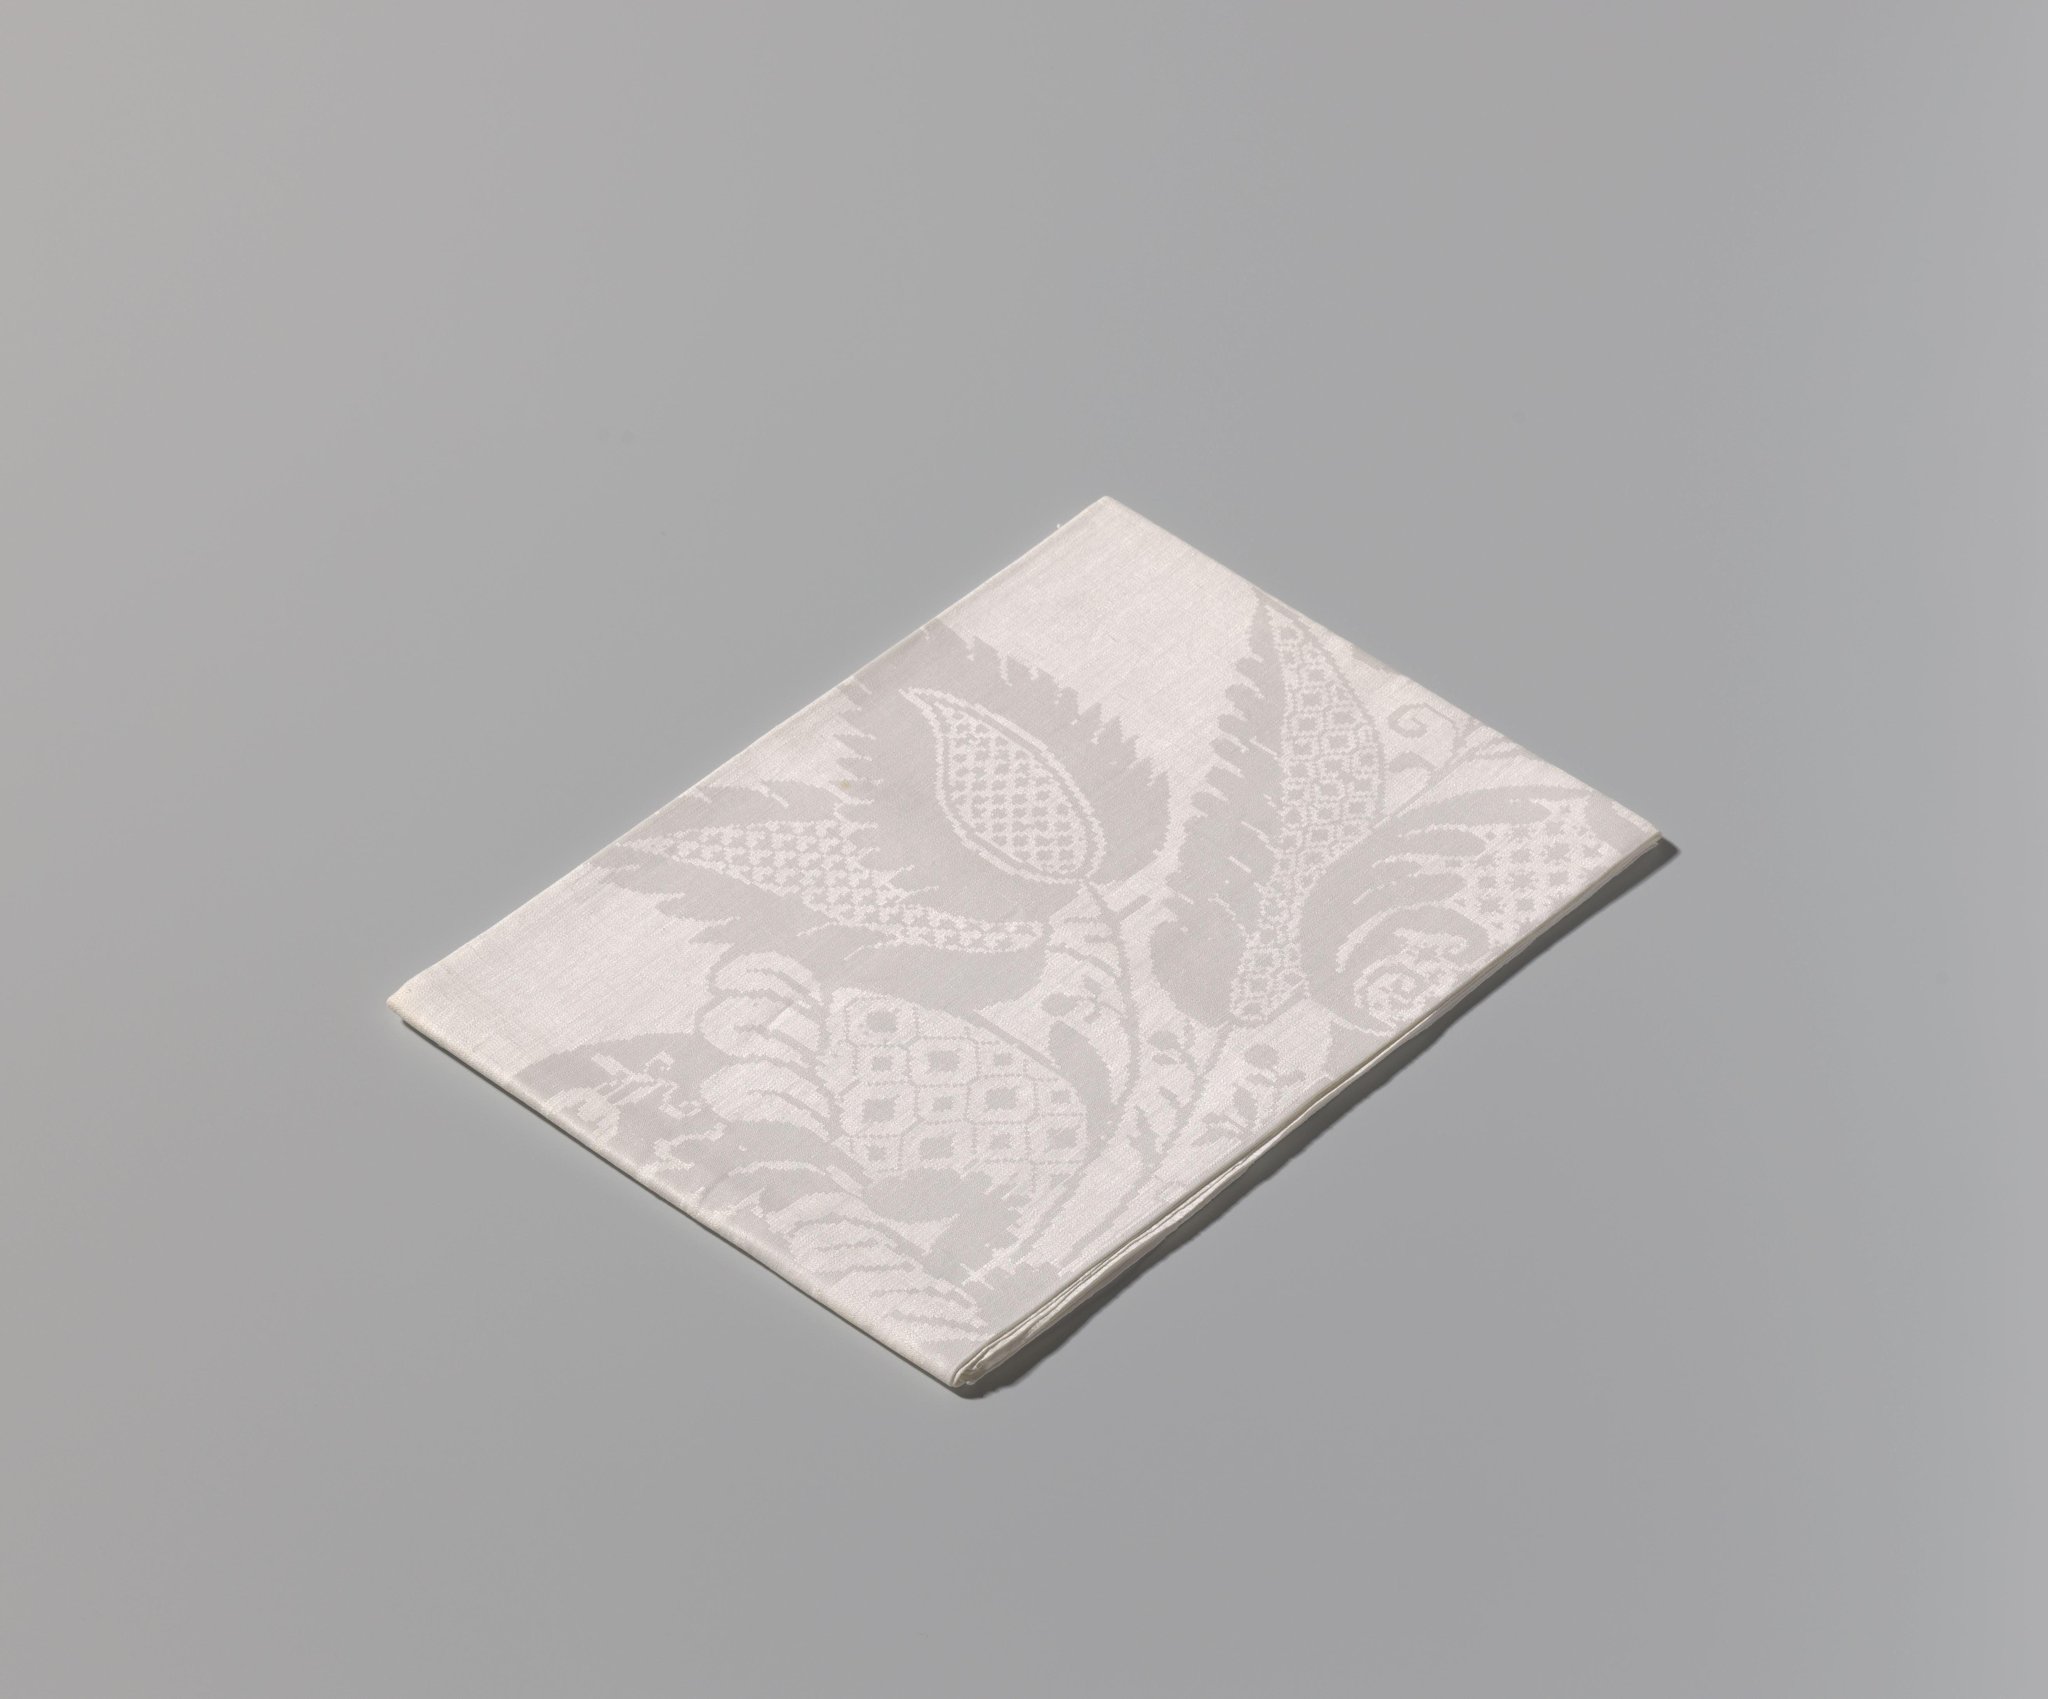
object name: napkin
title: Servet met een bloemboeket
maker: Anonymous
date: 1700-1749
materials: linen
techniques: damask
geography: netherlands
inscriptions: mark: ‘HP’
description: Servet van linnendamast. Ovale velden met binnenwaartse spits geschulpte rand dragen een bloemboeket van verbasterde granaatappel, voortkomende uit een afgeplatte bolvorm met schutbladeren. Binnenvullingen van rasterwerk. op de raakpunten rozetten, in de zwikken losse bloemtakken. twee smalle randen, de binnenste met dubbele rij aaneengeregen achthoekjes met stermotief, de buitenste met lopende bloemrank. Rondom een T-rand.